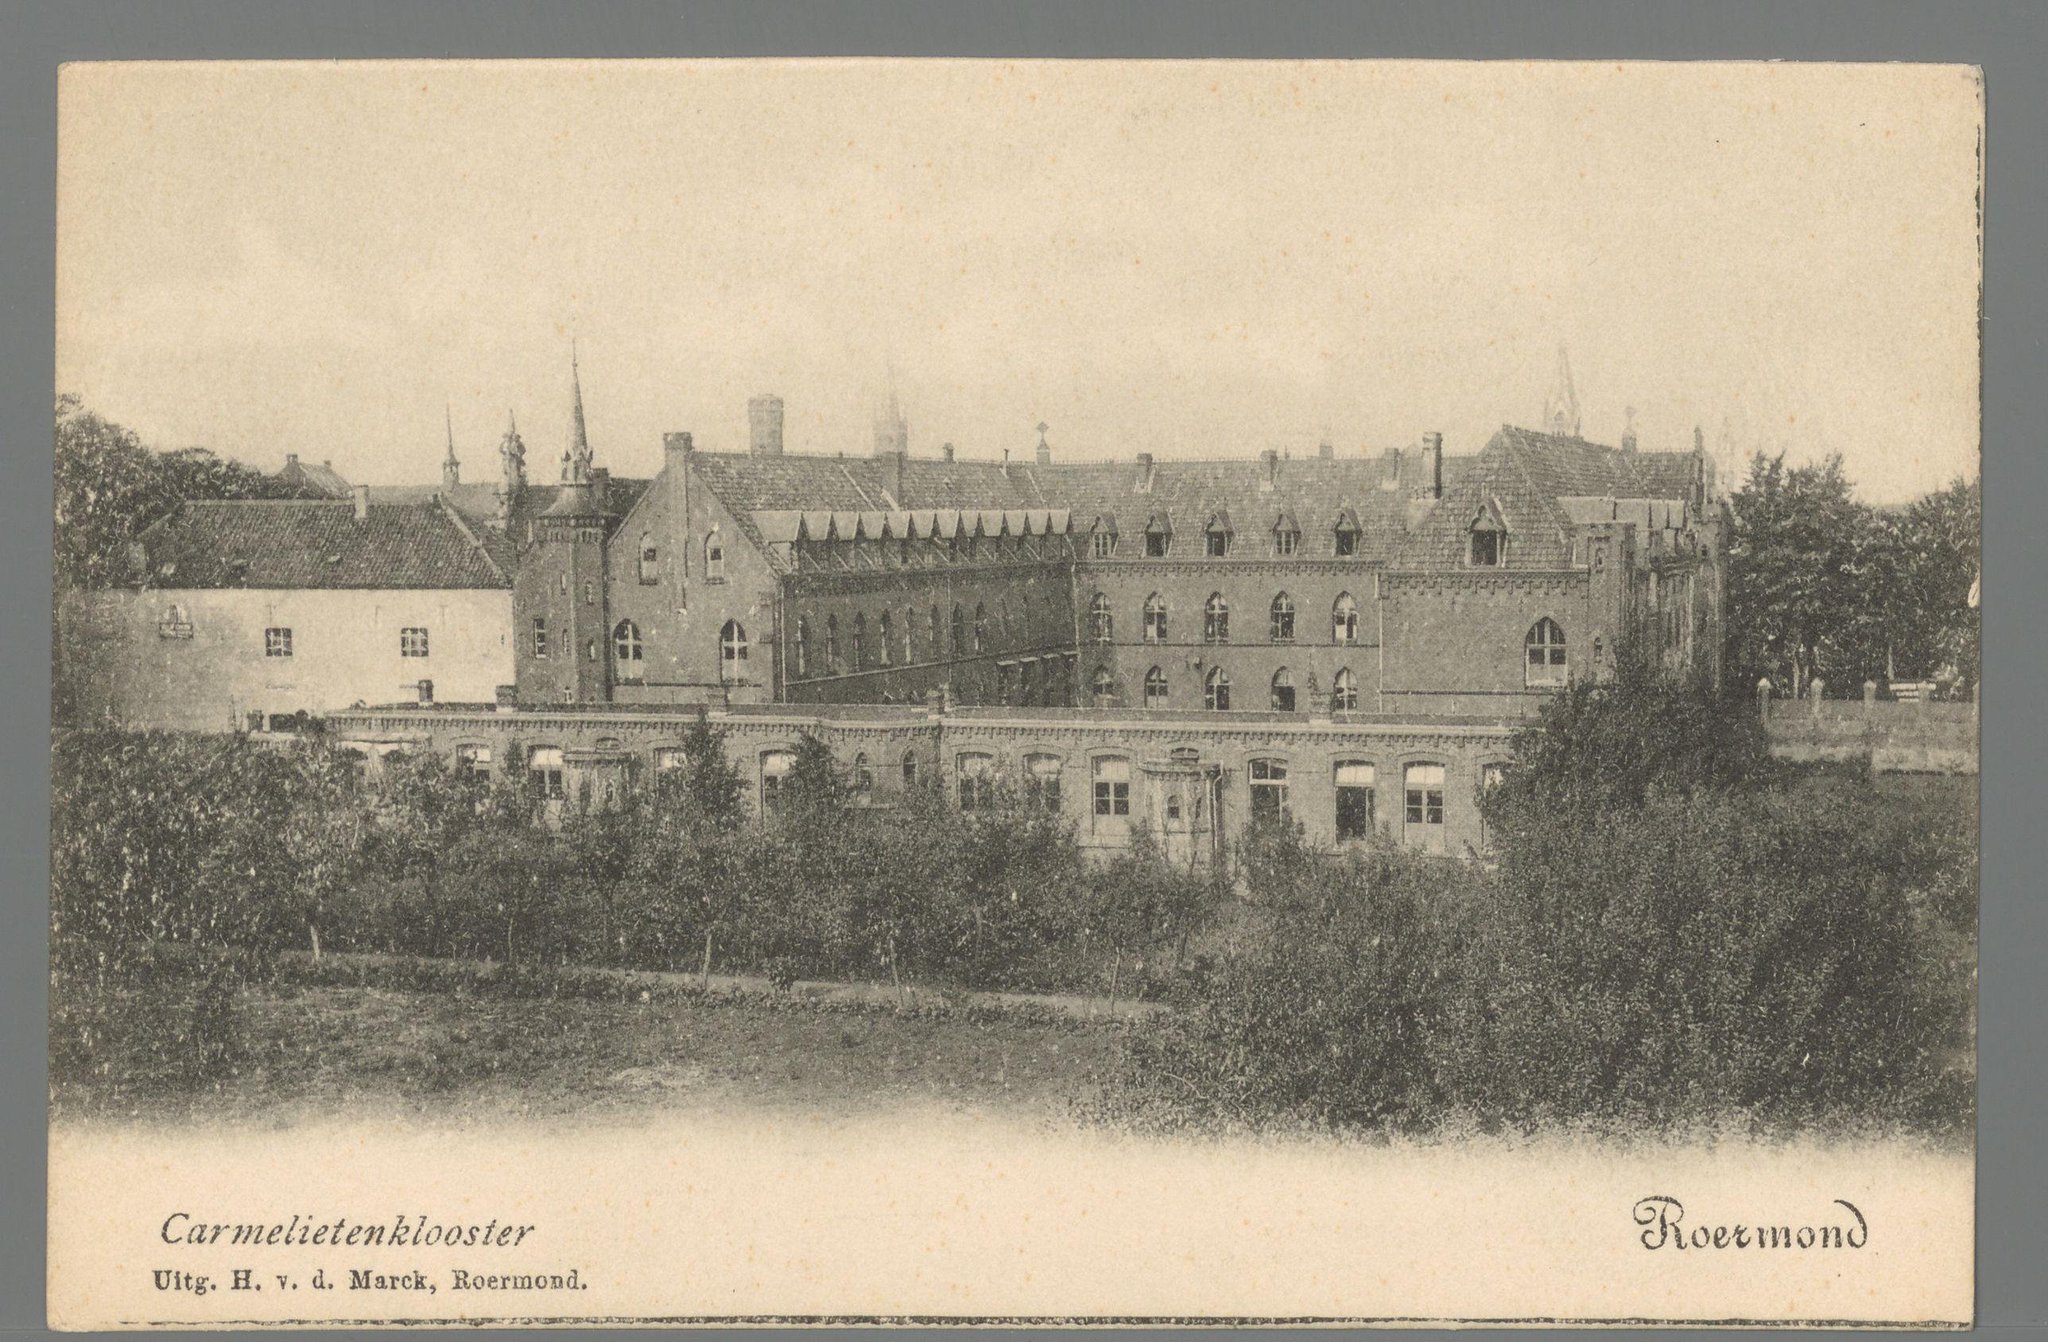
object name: photomechanical print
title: Carmelietenklooster. Roermond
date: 1897-1905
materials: cardboard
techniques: photograph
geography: roermond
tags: abbey, monastery, convent ~ roman catholic church